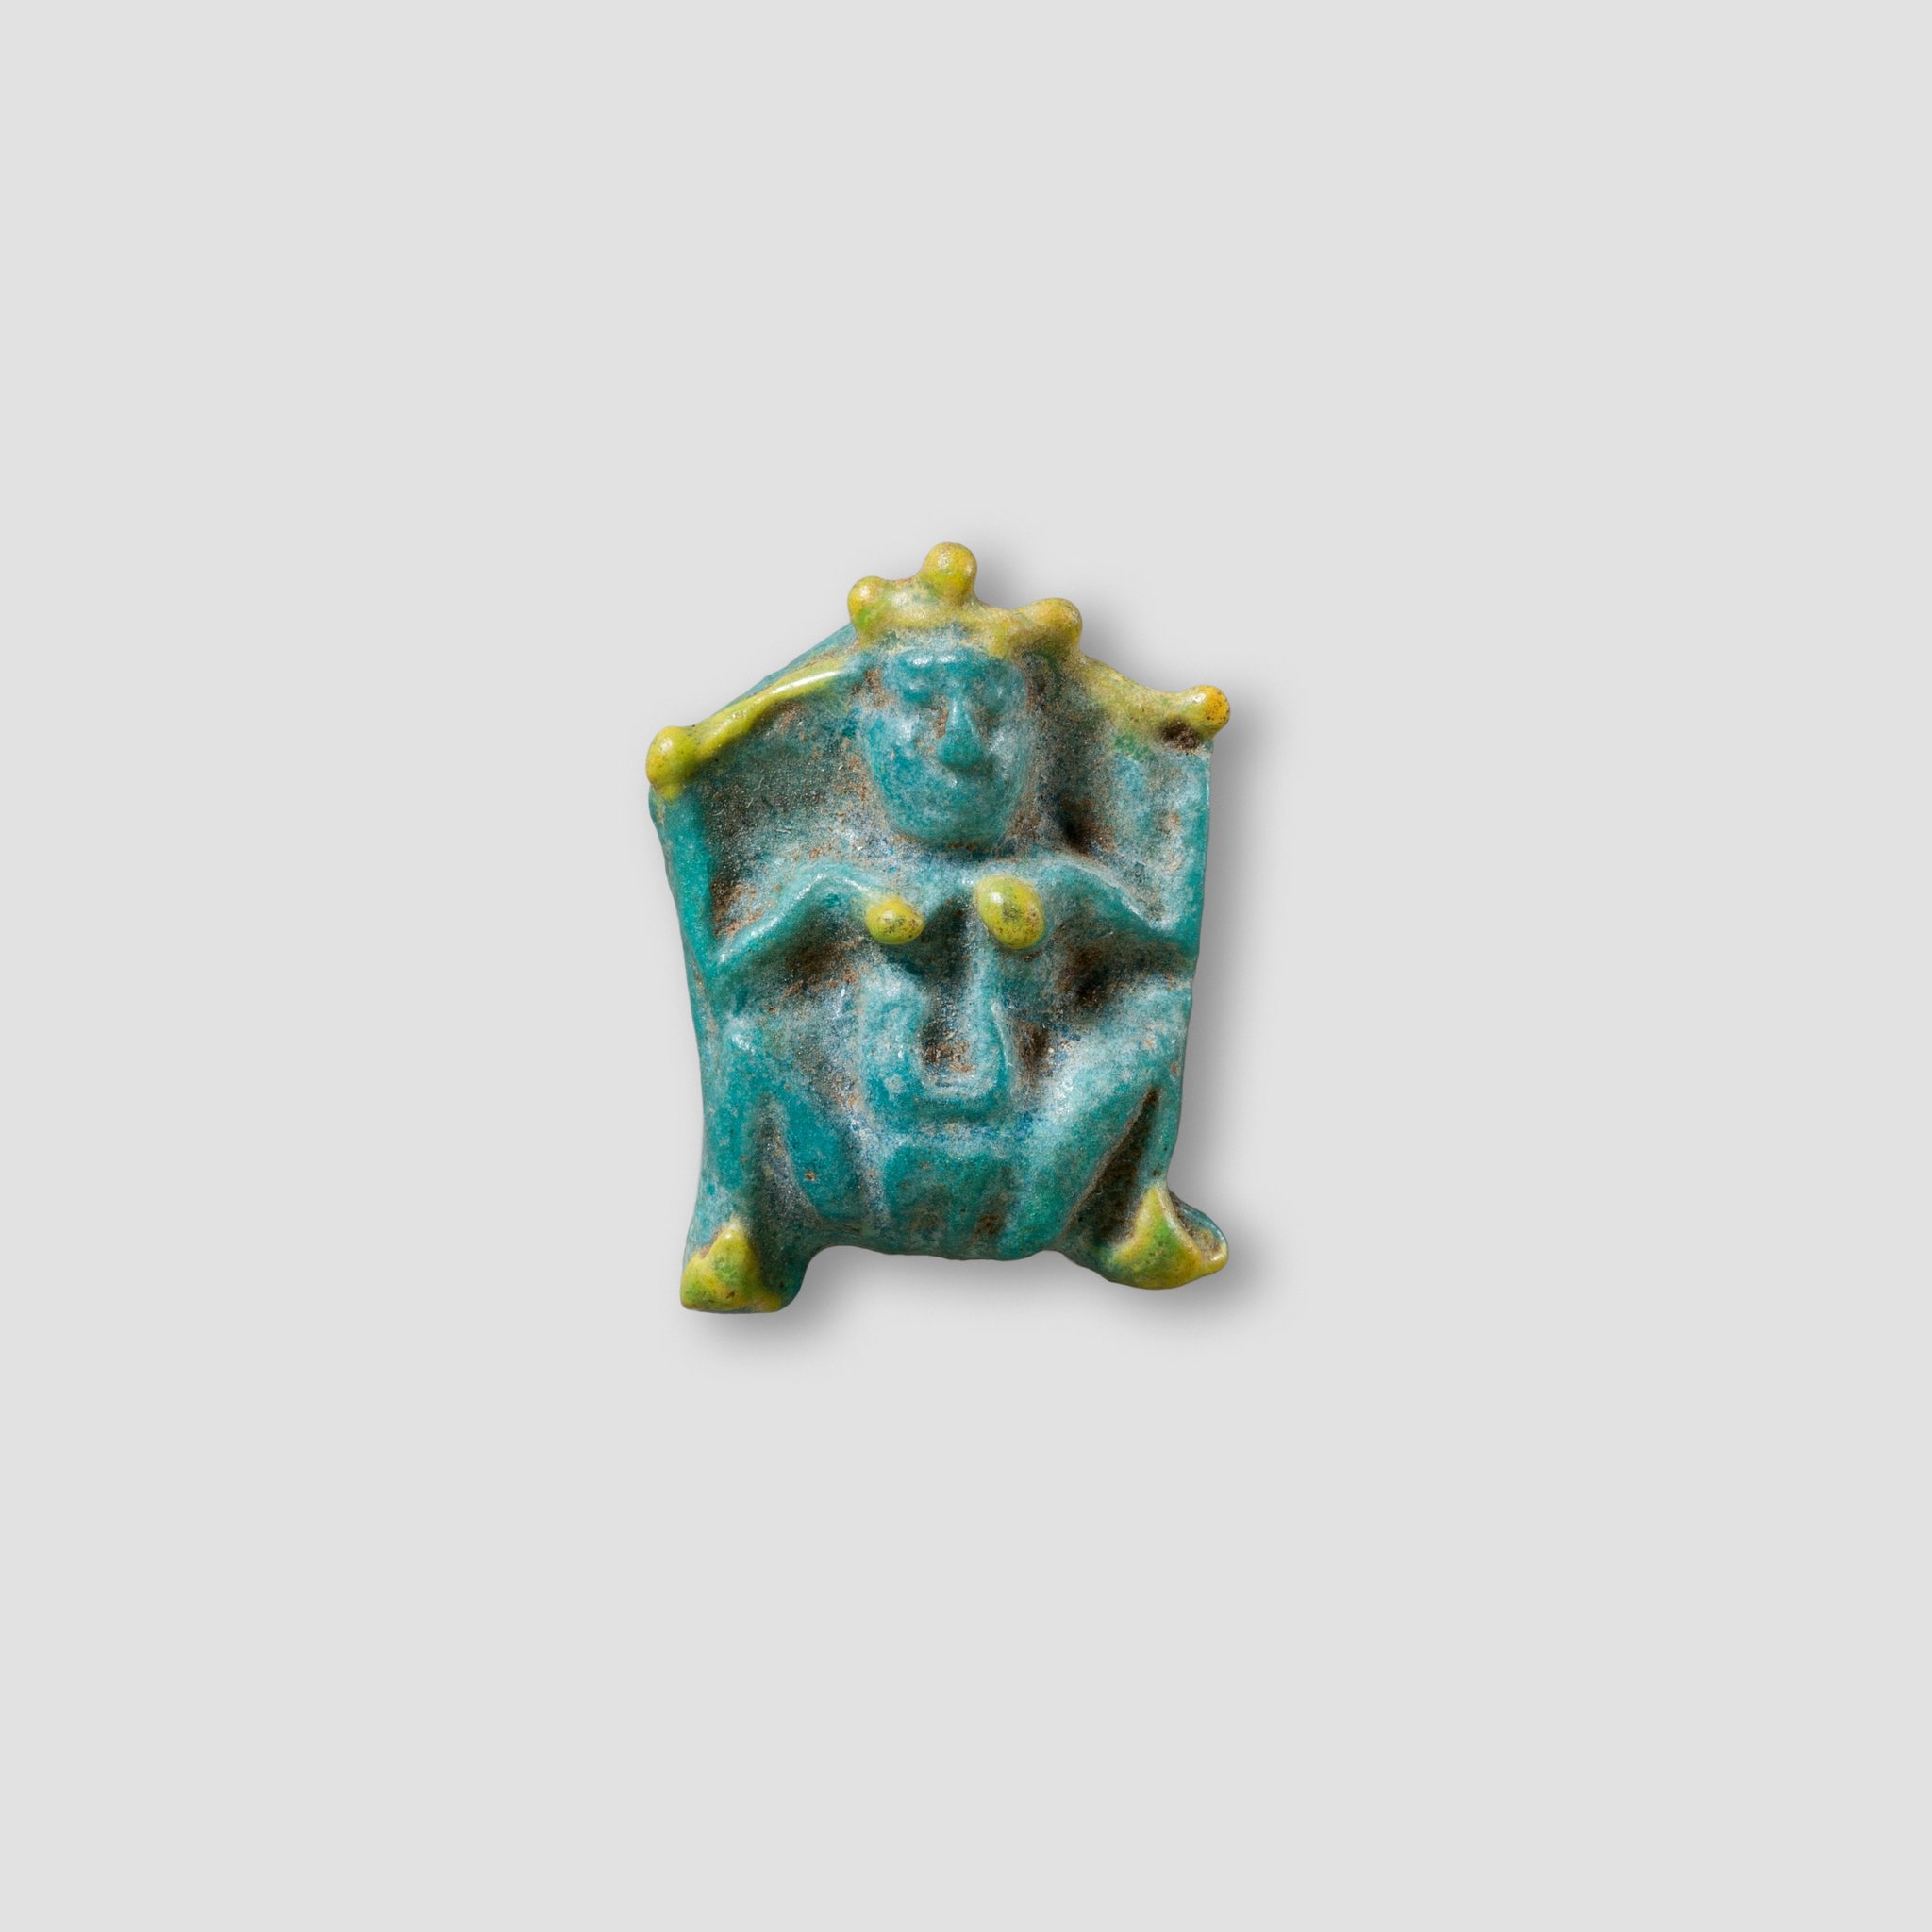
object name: amulet, omphale figure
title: Omphale figure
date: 100 BCE-300 CE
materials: faience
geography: egypt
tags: women